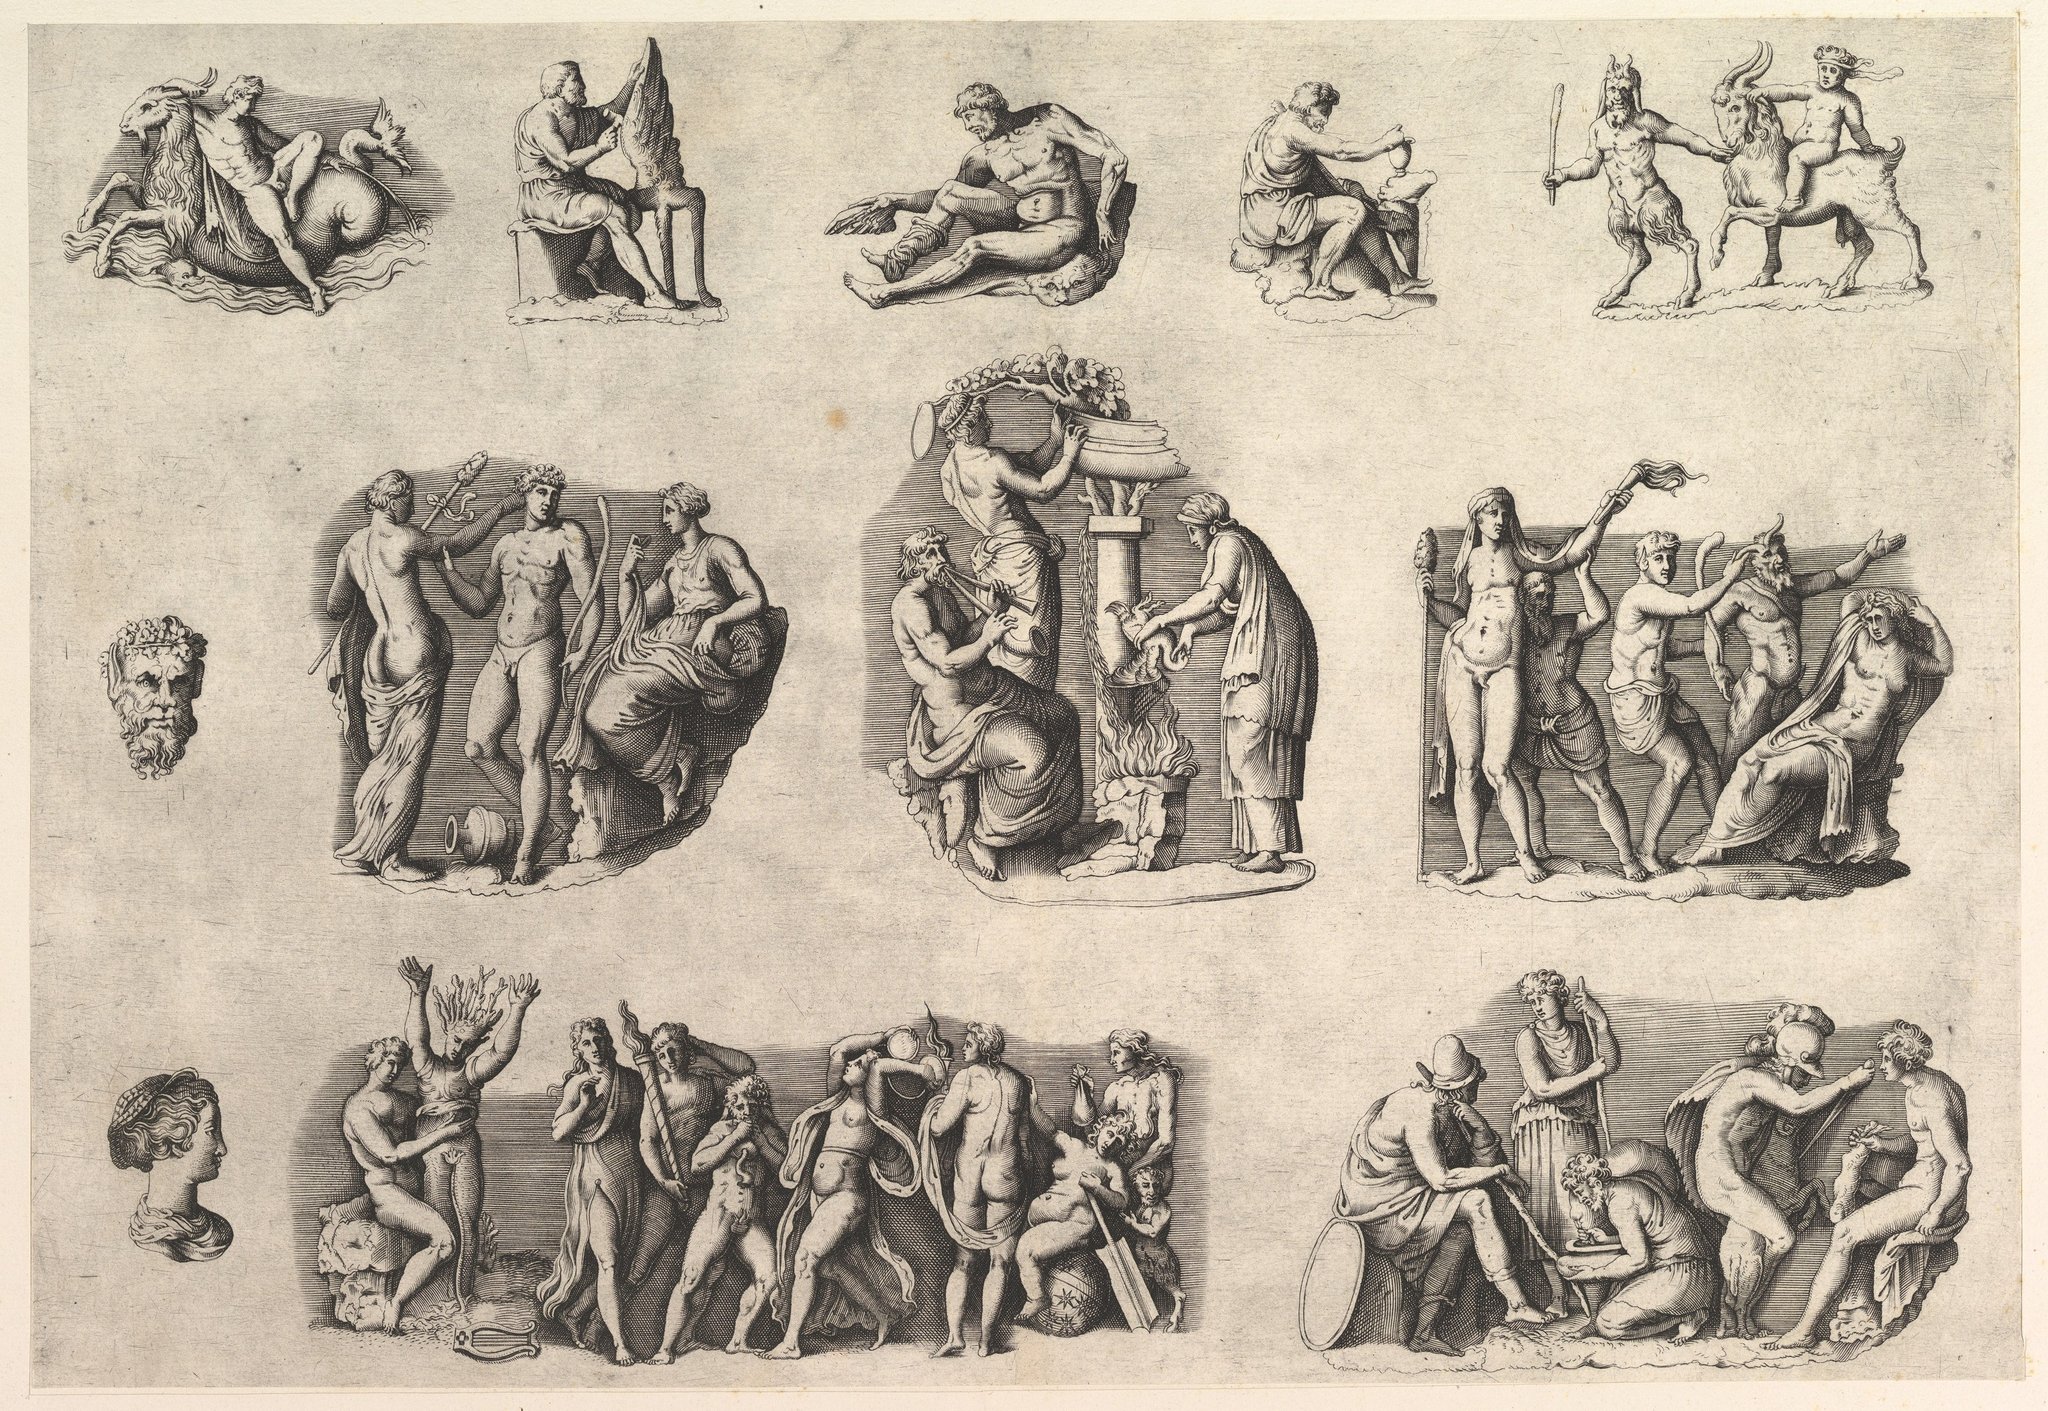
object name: print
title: Subjects after Antique Cameos and Gems, from "Speculum Romanae Magnificentiae"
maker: anonymous, italian, 16th century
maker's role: artist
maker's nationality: italian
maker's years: 1500-1600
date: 1550-1577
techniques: engraving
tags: weapons,faces,male nudes,female nudes